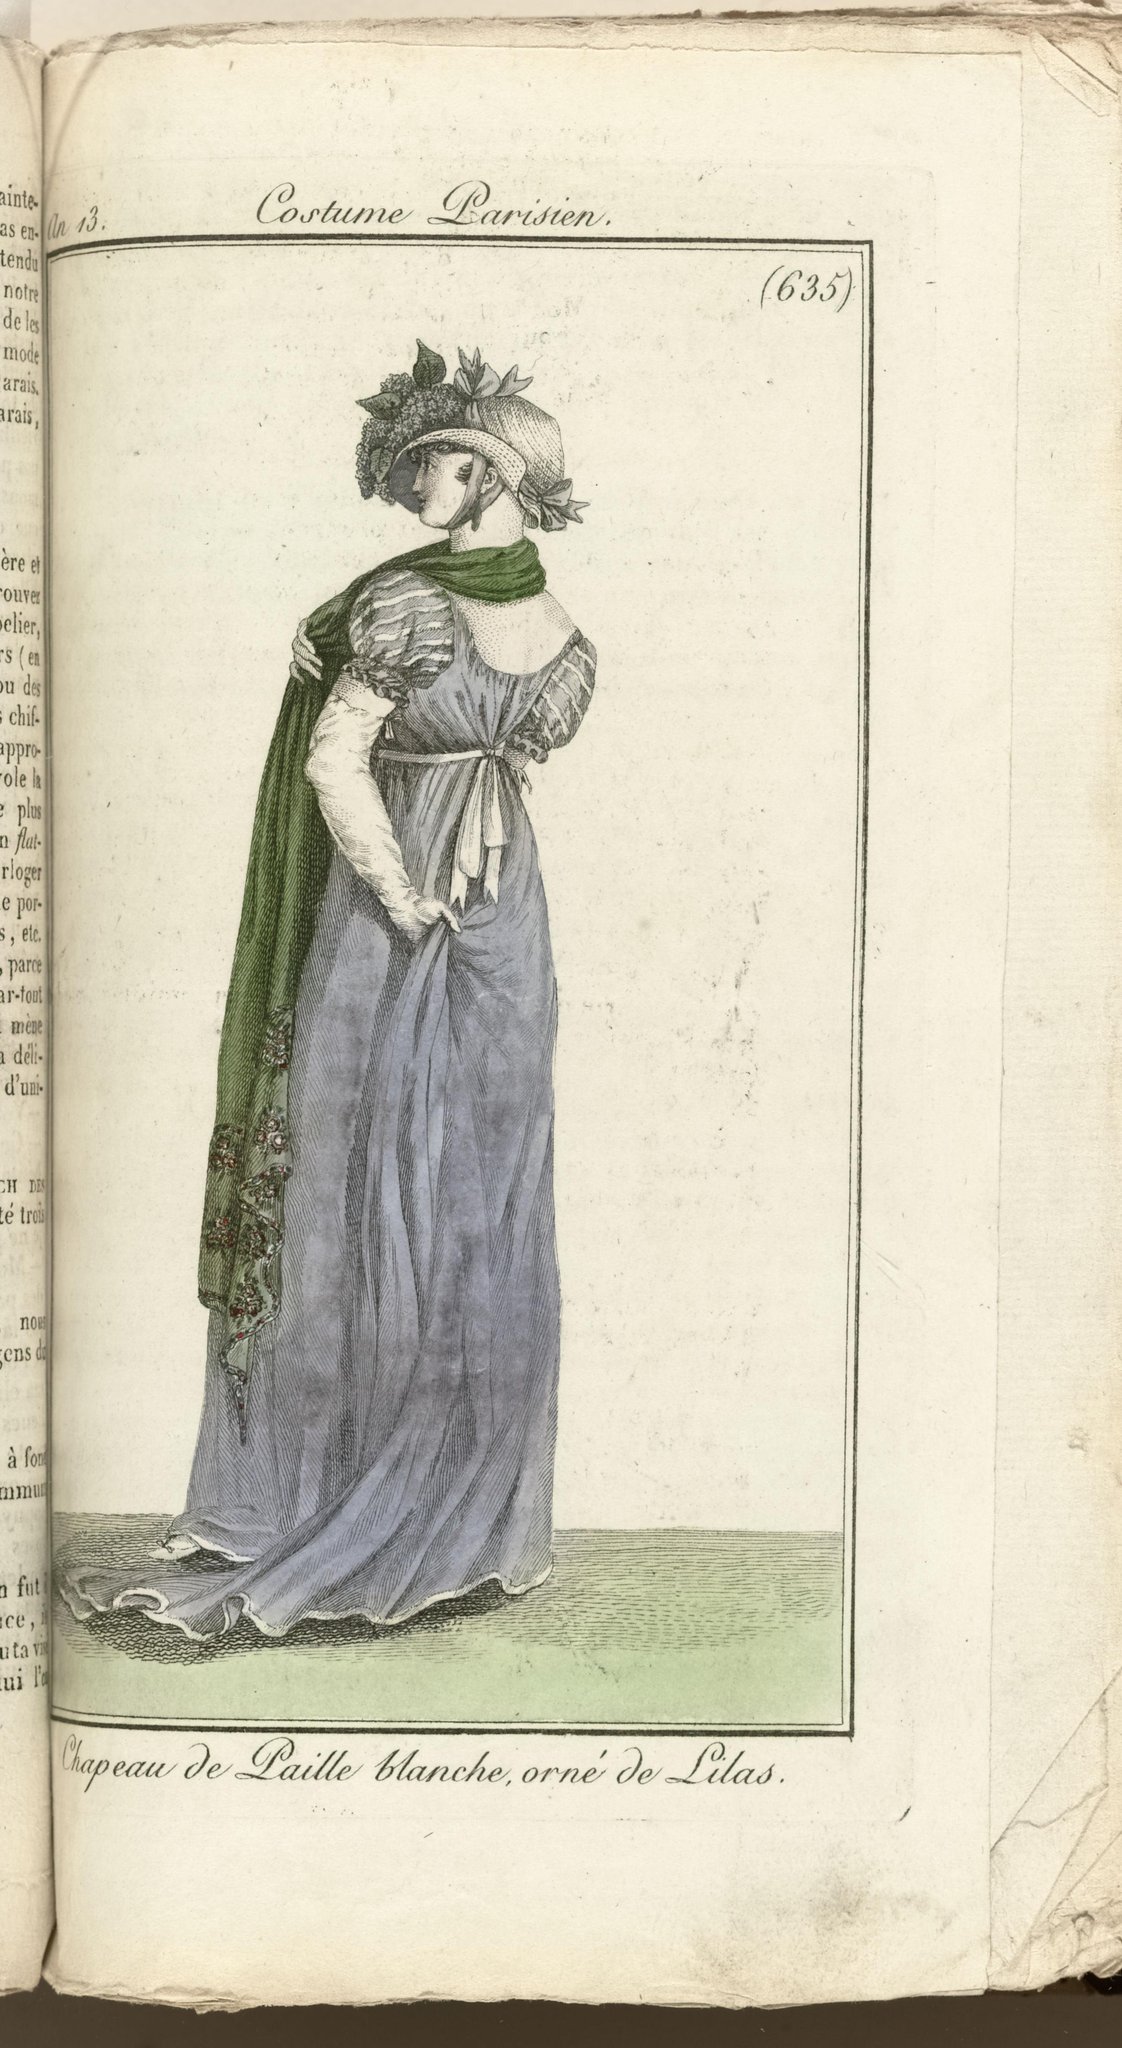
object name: fashion print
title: Journal des Dames et des Modes, Costume Parisien, 1805, An 13 (635) Chapeau de Paille blanche...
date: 1805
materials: paper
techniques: engraving, hand coloring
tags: gloves, mittens (long gloves) (+ women's clothes), neck-gear ~ clothing (shawl) (+ women's clothes), fashion plates, head-gear: hat (+ women's clothes), dress, gown (+ women's clothes), belt, girdle, waistband (+ women's clothes)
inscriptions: title: ‘Chapeau de Paille blanche, ornée de Lilas’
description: Vrouw op de rug gezien, in een paarse japon met gestreepte pofmouwtjes en een wit lint om de hoge taille gestrikt. Op het hoofd een witte strohoed, met een paars lint onder kin gebonden en versierd met hyacinthen. Witte lange handschoenen en een lange groene sjaal om de hals. De prent maakt deel uit van het modetijdschrift Journal des Dames et des Modes, uitgegeven door Pierre de la Mésangère, Parijs, 1797-1839.